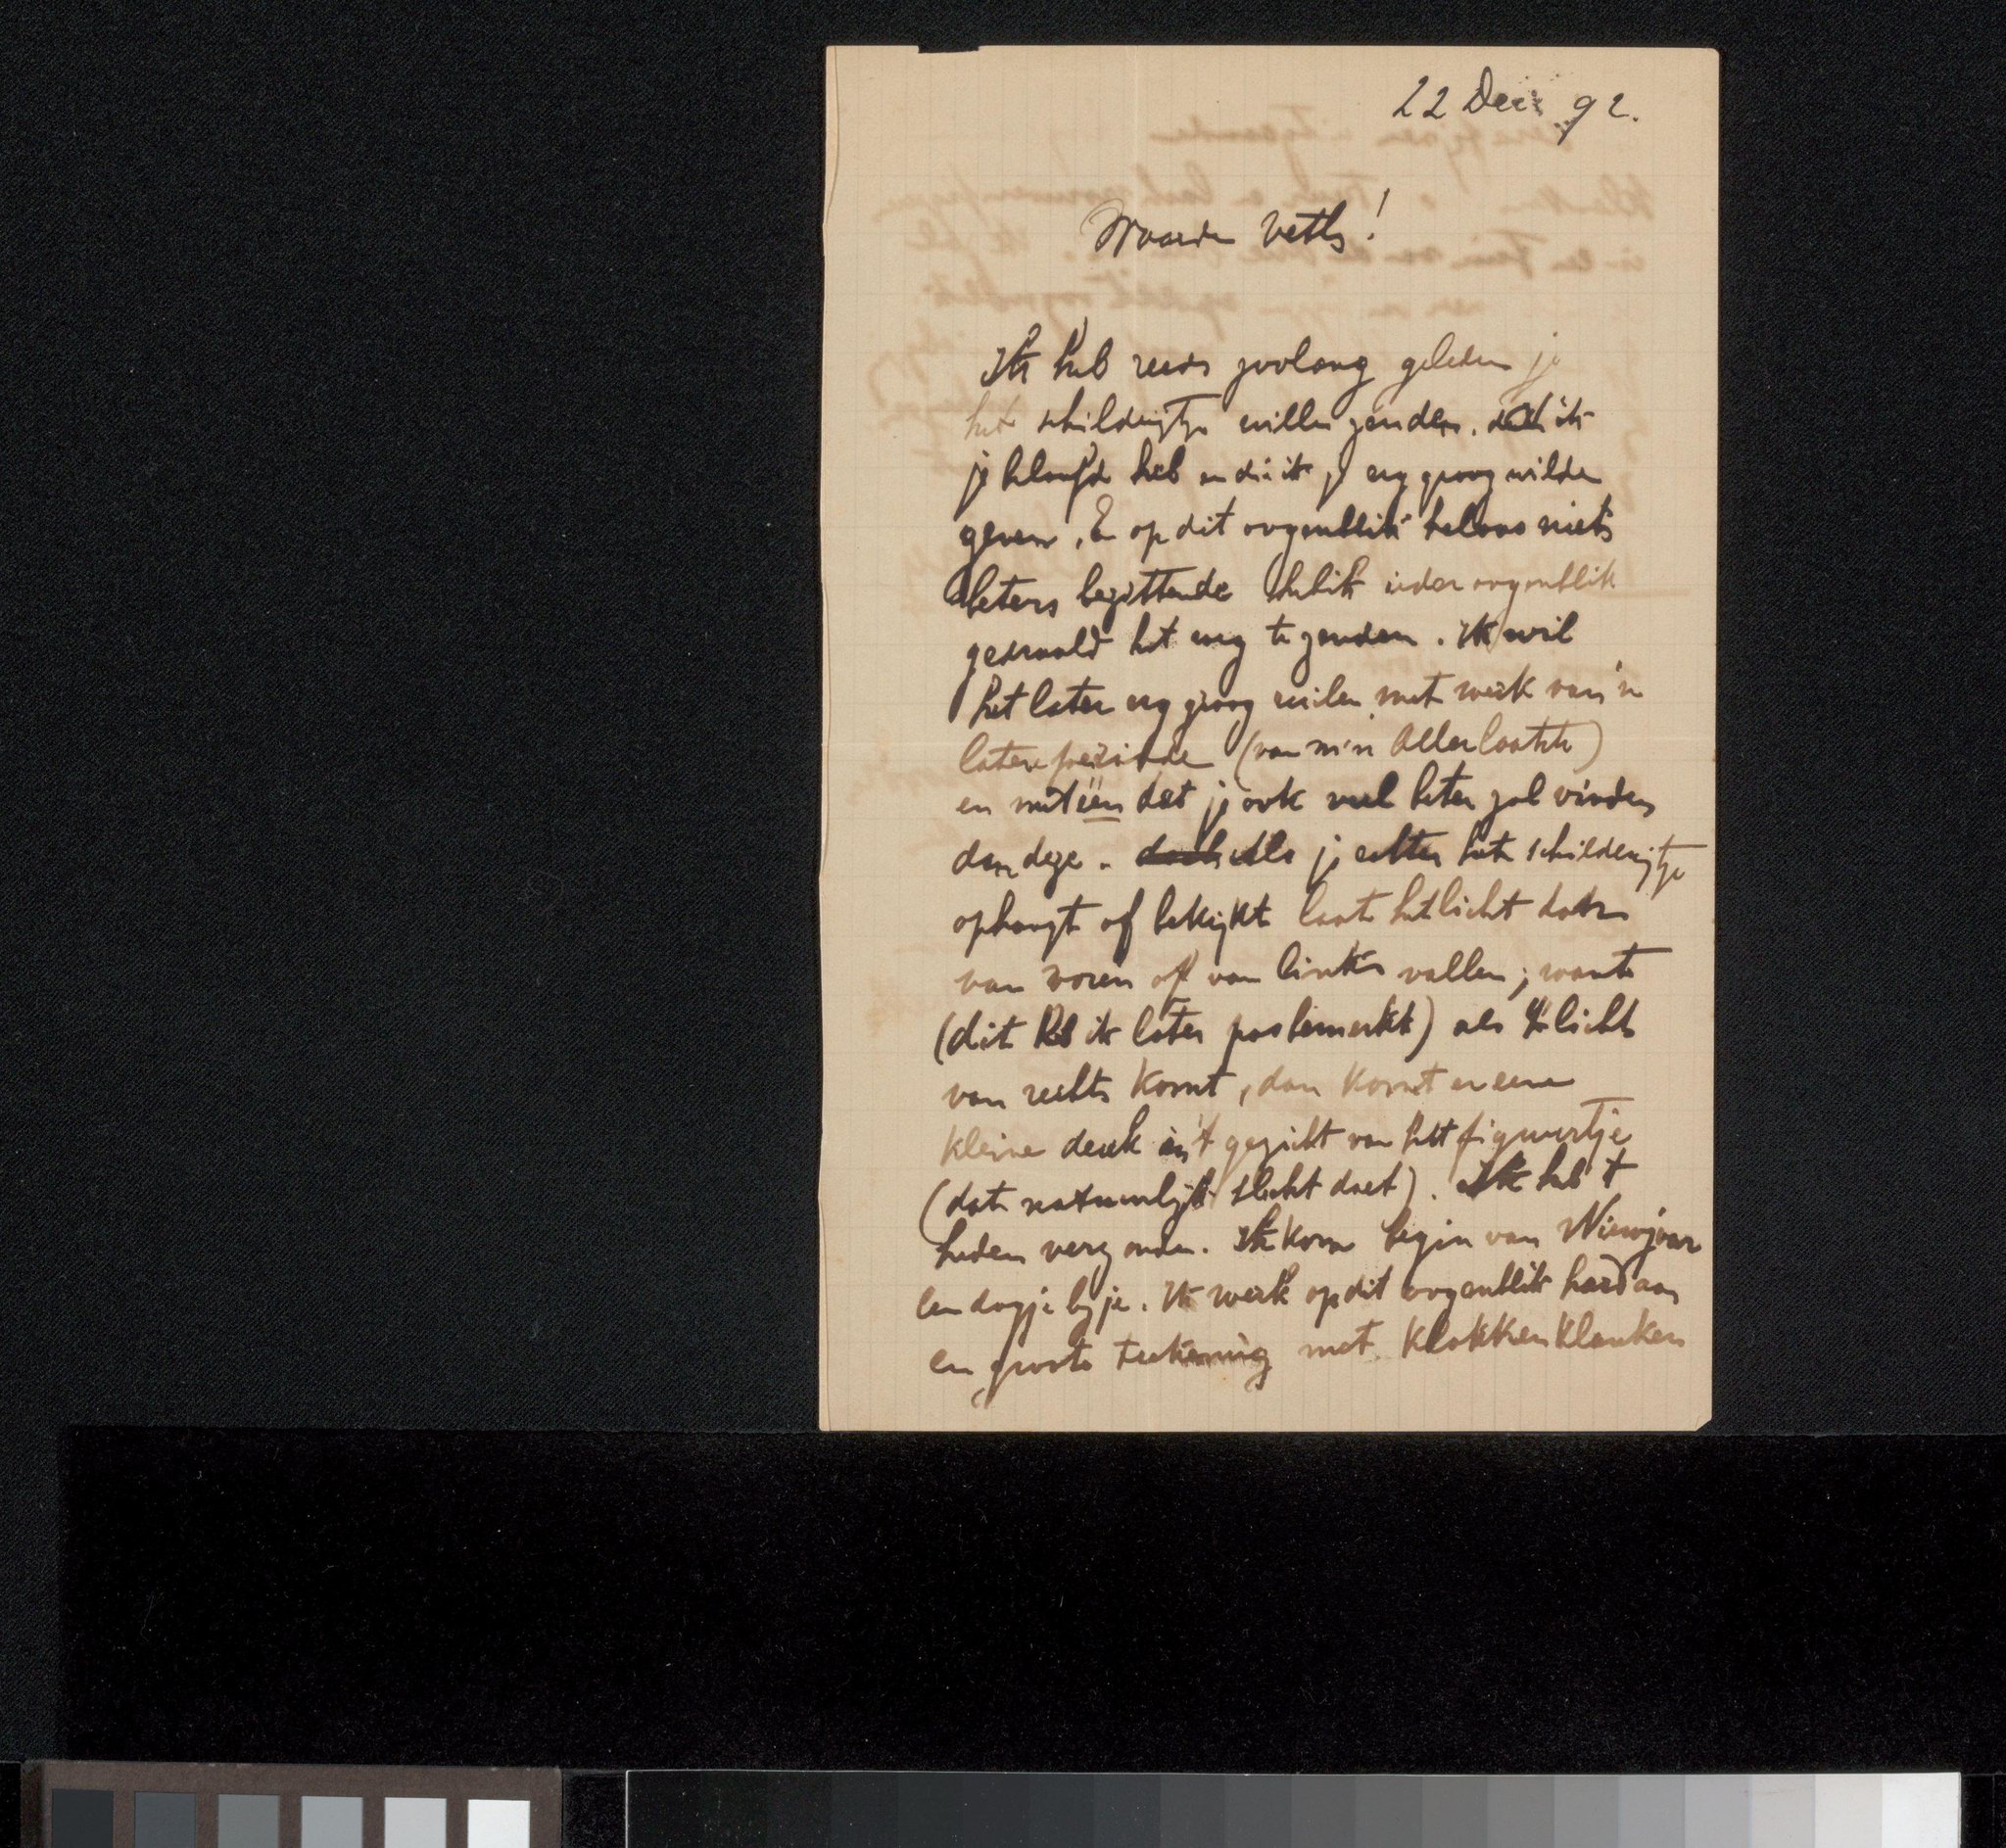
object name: letter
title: Brief aan Jan Veth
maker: jan toorop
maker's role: draughtsman, painter, print maker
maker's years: 1858-1928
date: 1874-1925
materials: ink, paper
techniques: pen, writing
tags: dordrecht, amsterdam, designer, jan veth, drawing, illustration ~ printed matter, book, painting (including book-illumination, miniature-painting)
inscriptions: collector's mark: ‘RPK’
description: Brief gedateerd 22 Dec: 92 in latere hand.